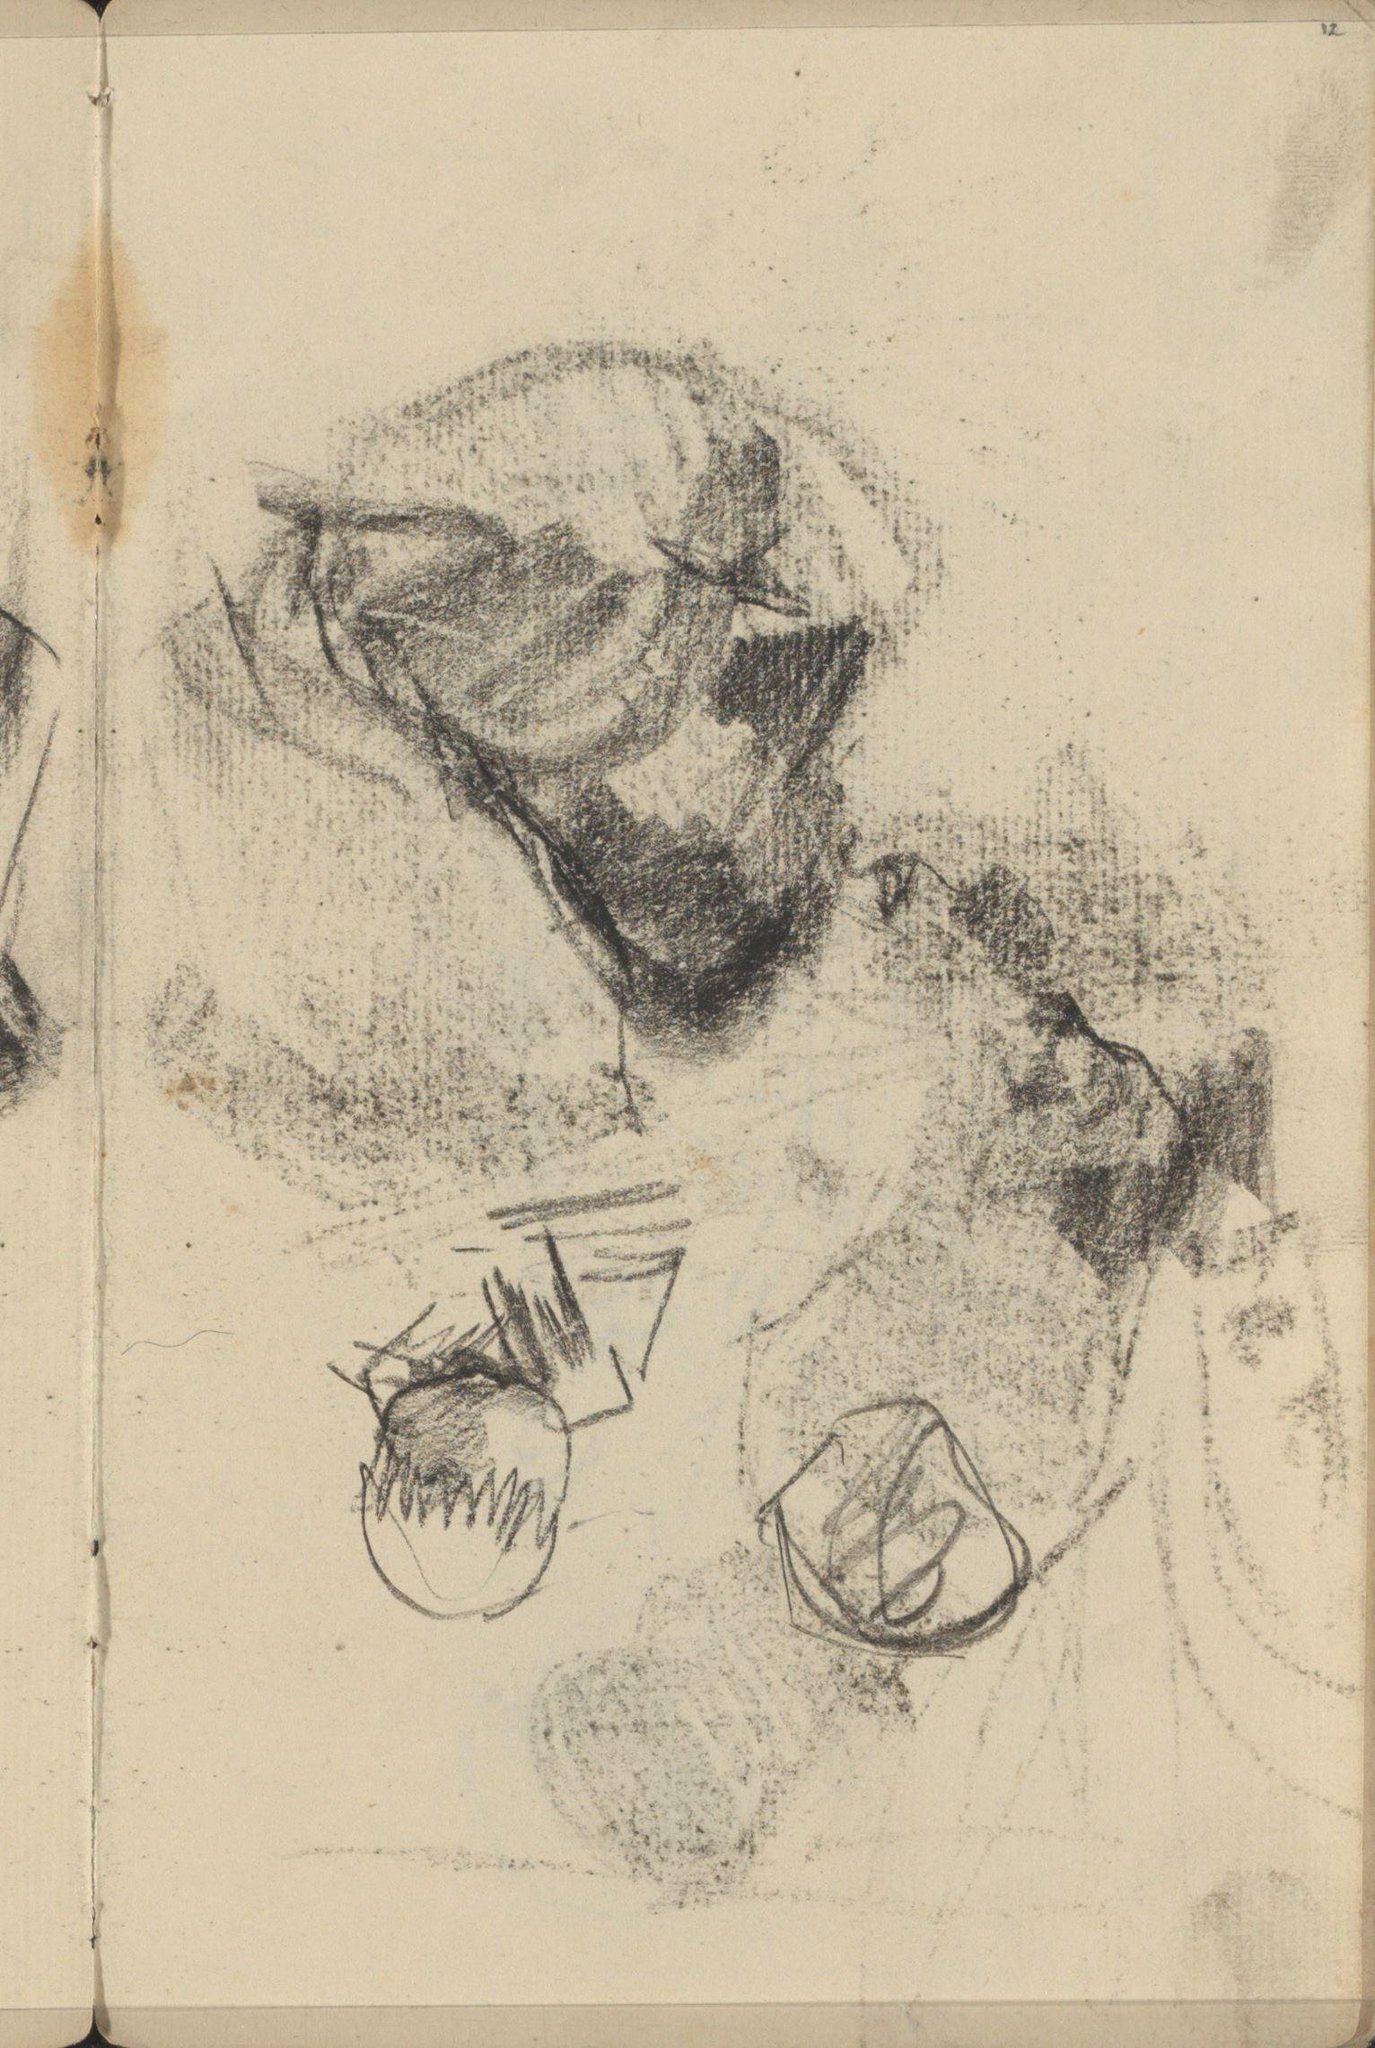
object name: sketchbook leaf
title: Figuurstudies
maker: george hendrik breitner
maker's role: draughtsman, painter, print maker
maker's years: 1857-1923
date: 1880-1882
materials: chalk, paper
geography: the hague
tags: child, head (human) - aa - female human figure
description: Vrouw met gebogen hoofd en mogelijk kinderhoofden. Pagina 12 uit een schetsboek met 19 bladen.